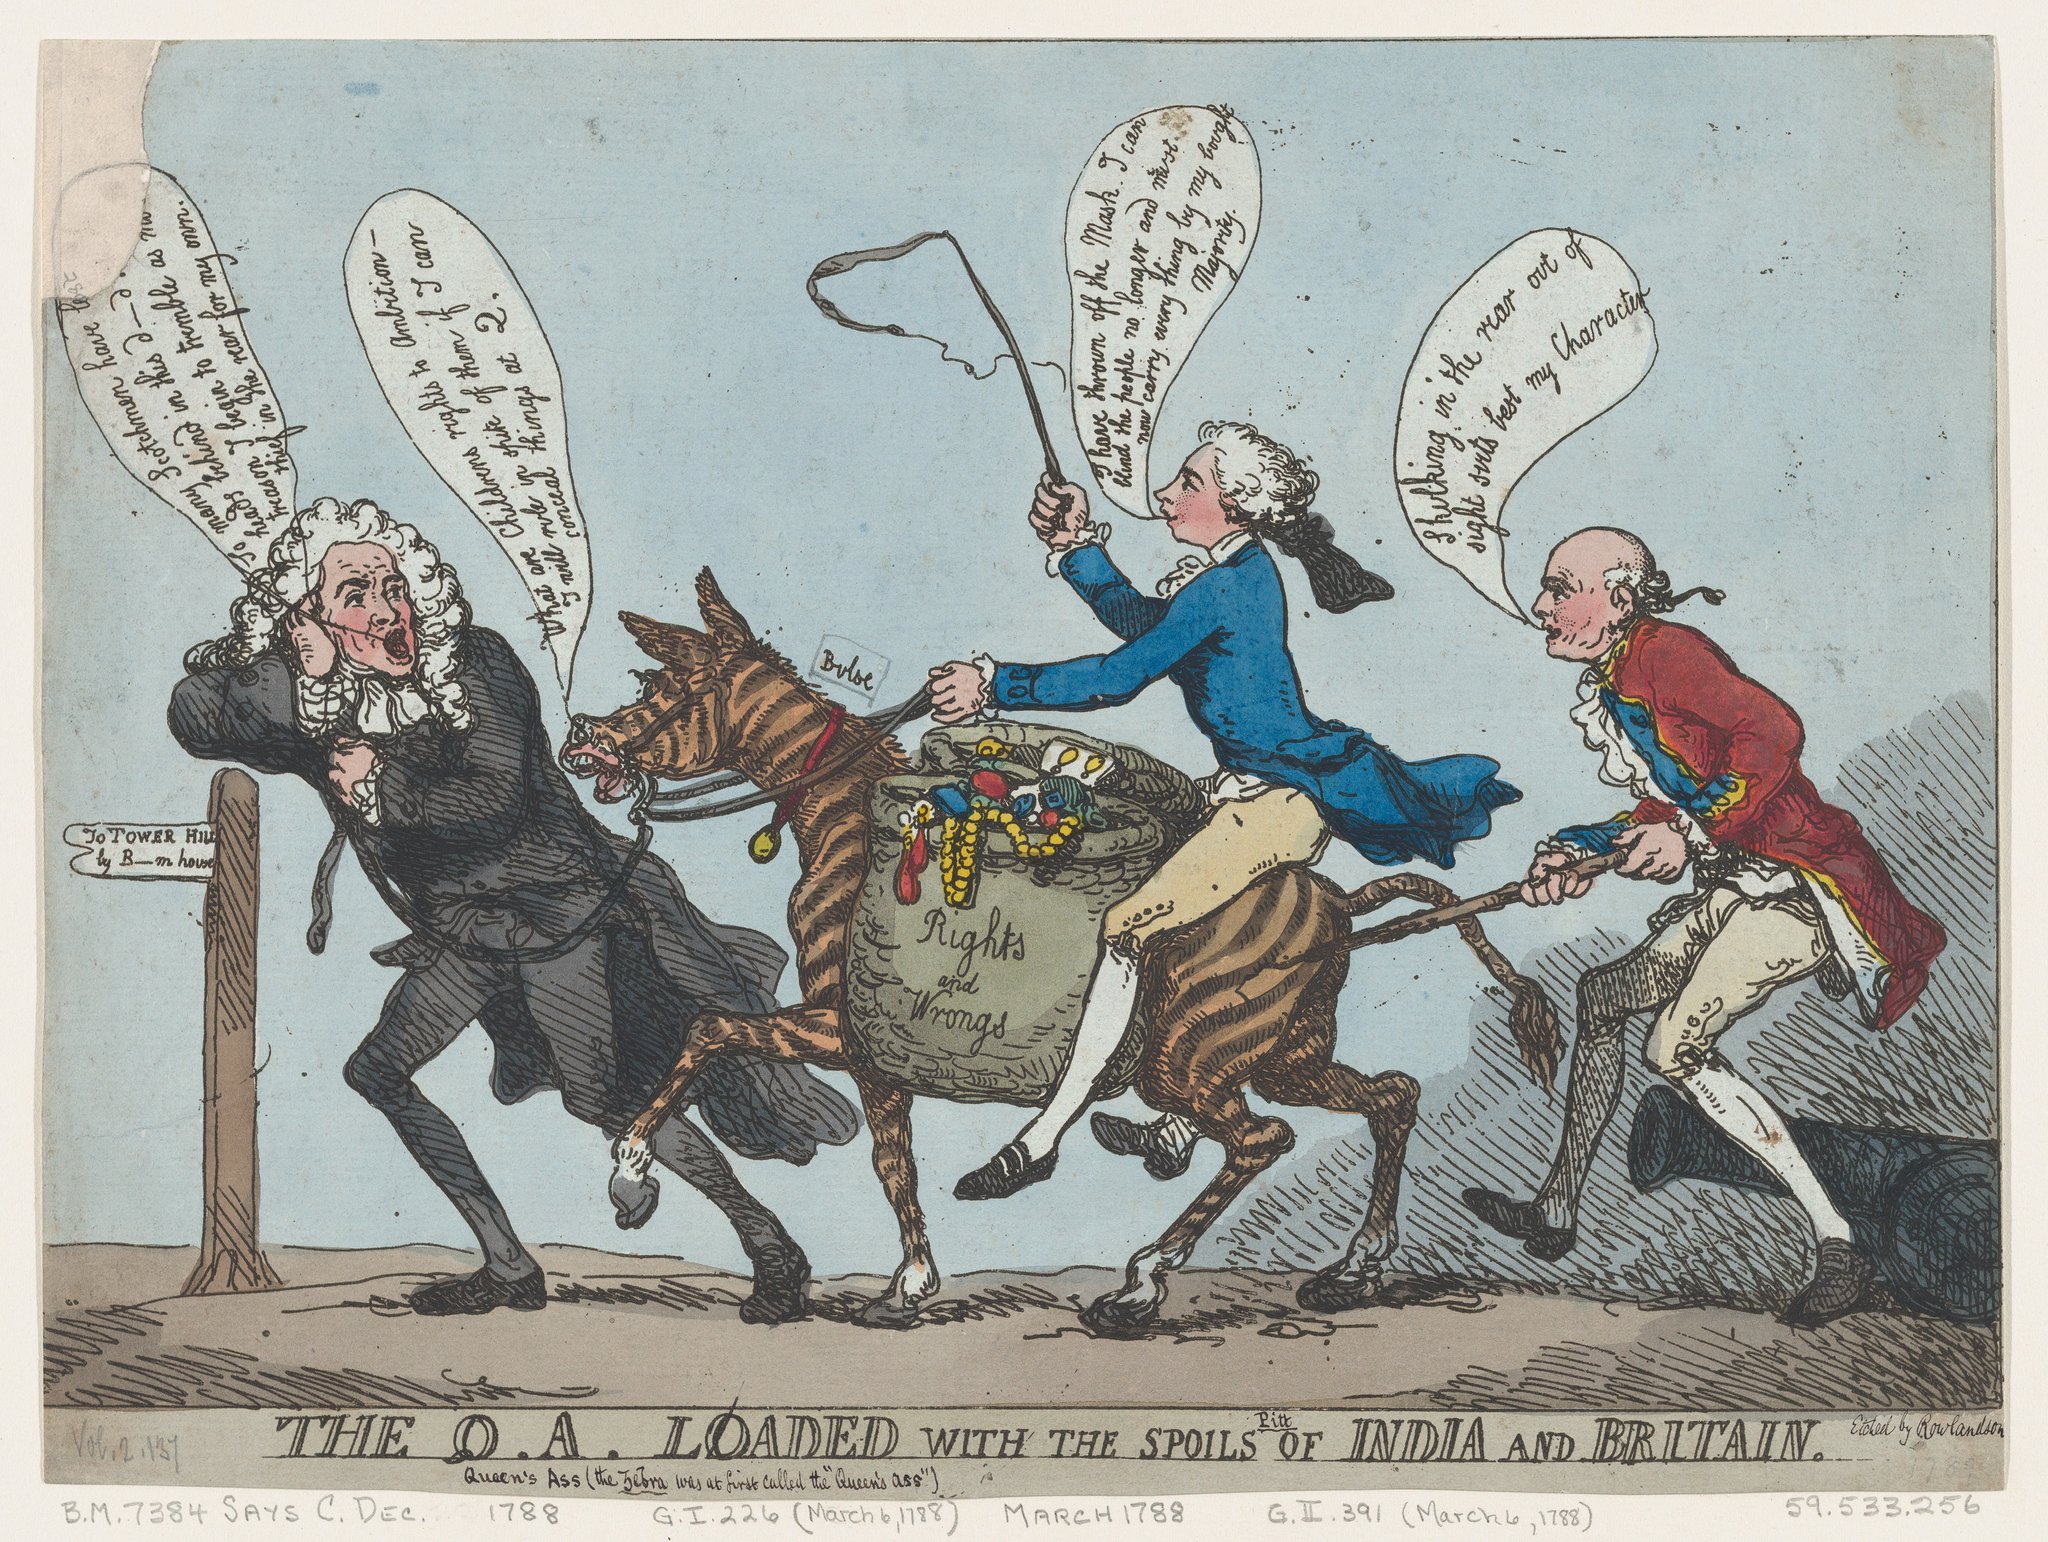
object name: print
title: The Q.A. Loaded With The Spoils of India and Britain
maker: thomas rowlandson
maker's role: artist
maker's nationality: british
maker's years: 1757-1827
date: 1788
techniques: aquatint, etching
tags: animals,satire,men